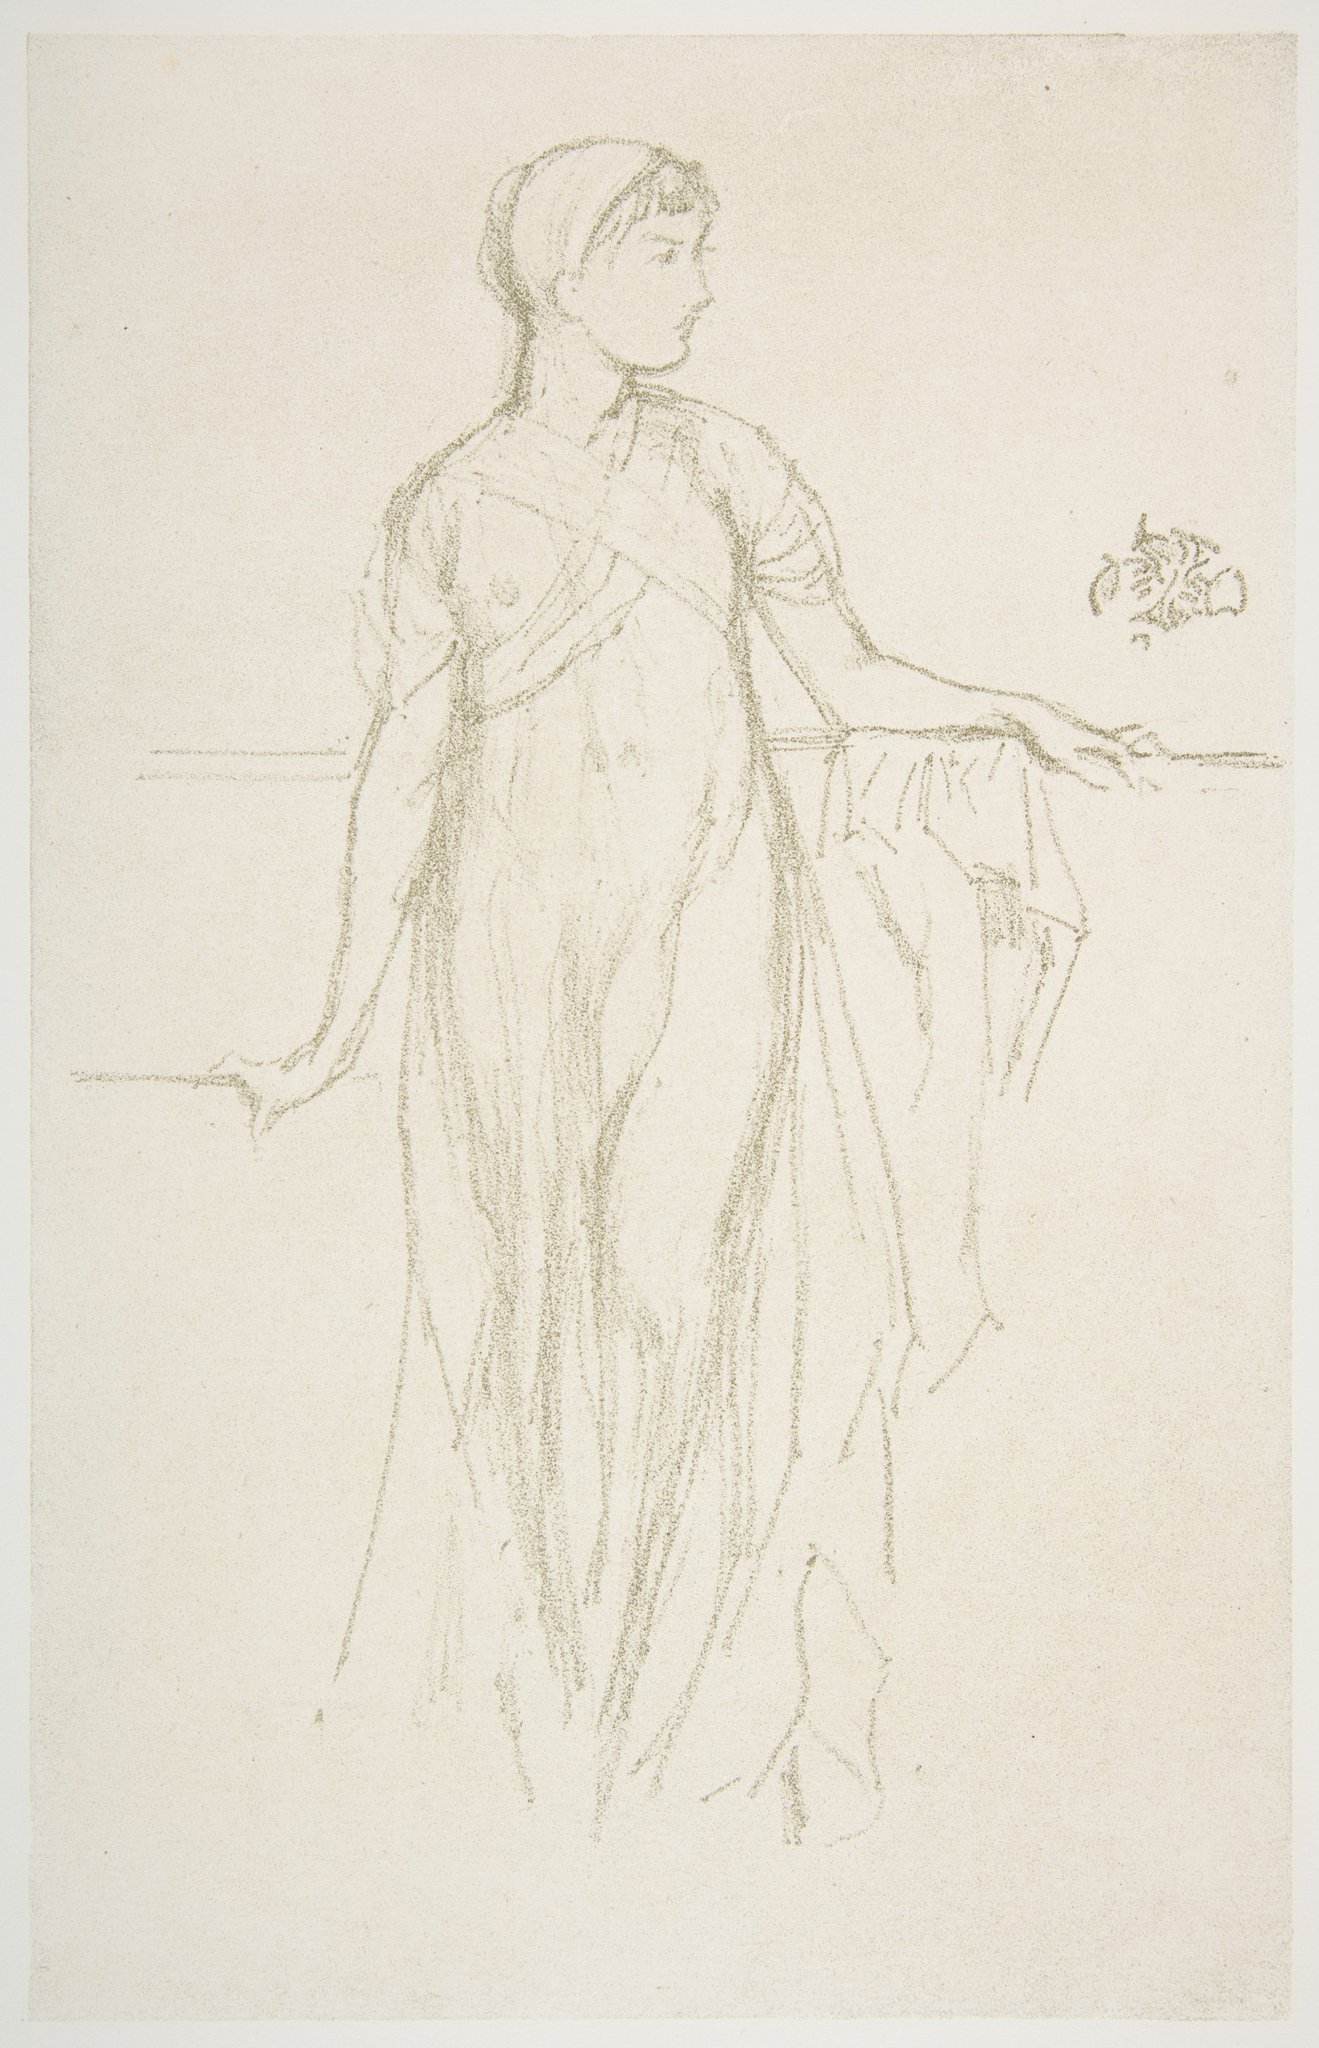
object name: print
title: Study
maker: james mcneill whistler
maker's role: artist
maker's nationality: american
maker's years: 1834-1903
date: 1879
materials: ink, paper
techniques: lithograph, printing, scraping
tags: women